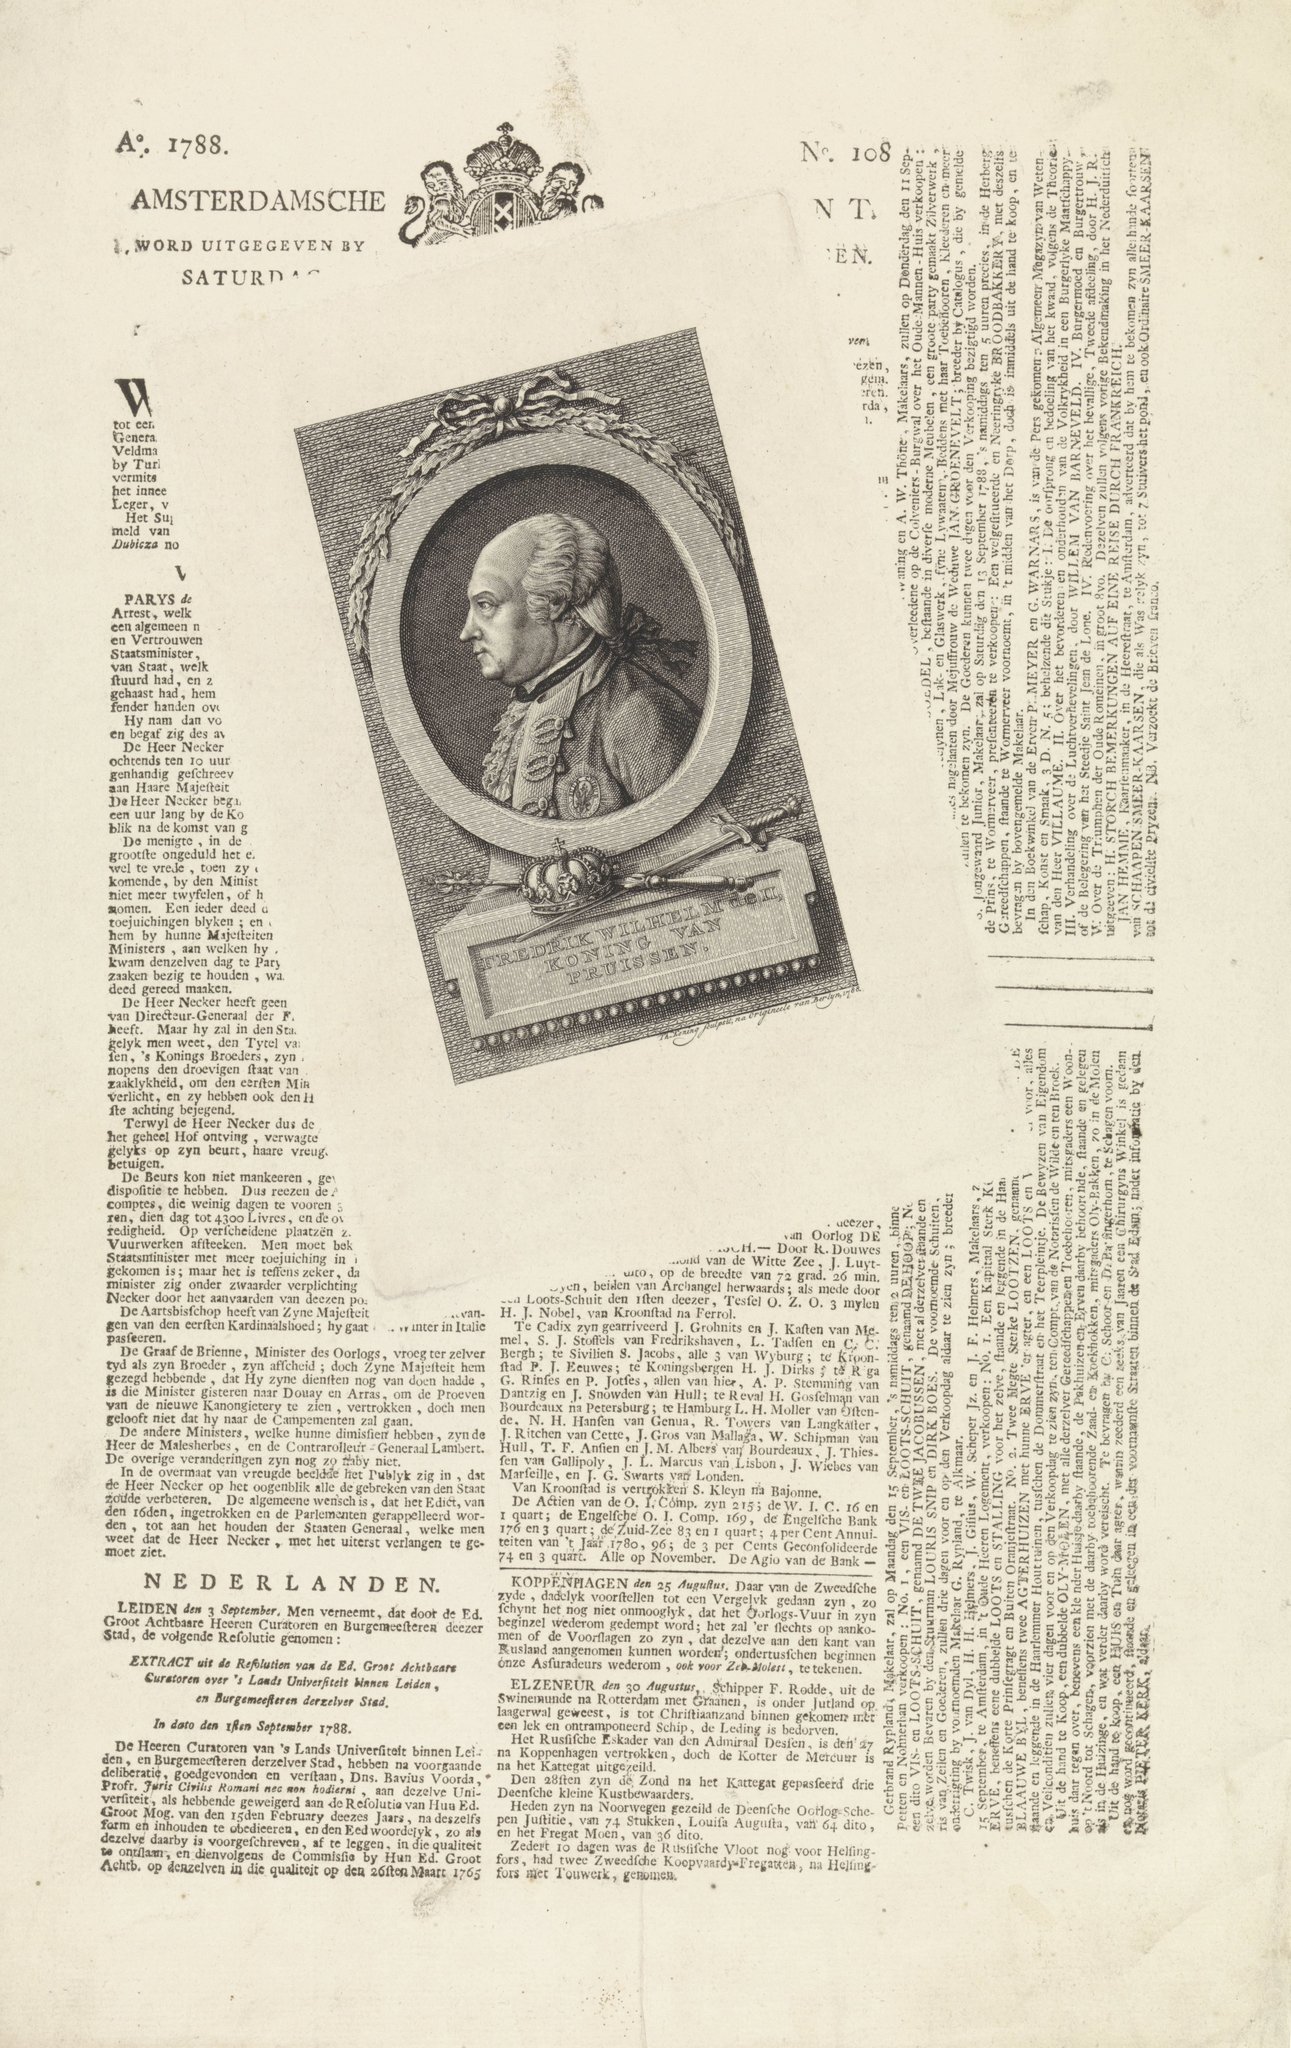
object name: print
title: Portret van Frederik Willem II, koning van Pruisen op een krant gedrukt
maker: theodoor koning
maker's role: print maker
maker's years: 1748-1829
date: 1788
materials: paper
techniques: engraving, etching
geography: amsterdam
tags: frederik willem ii (koning van pruisen), newspaper, news-sheet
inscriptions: collector's mark: Lugt 2228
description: Portretbuste van Frederik Willem II, koning van Pruisen. Hij draagt een strik in het haar. Onder zijn portret twee zwaarden en een kroon. In de plaquette onder de prent een drieregelige tekst. Het portret is gedrukt op een pagina van de krant 'Amsterdamsche'.